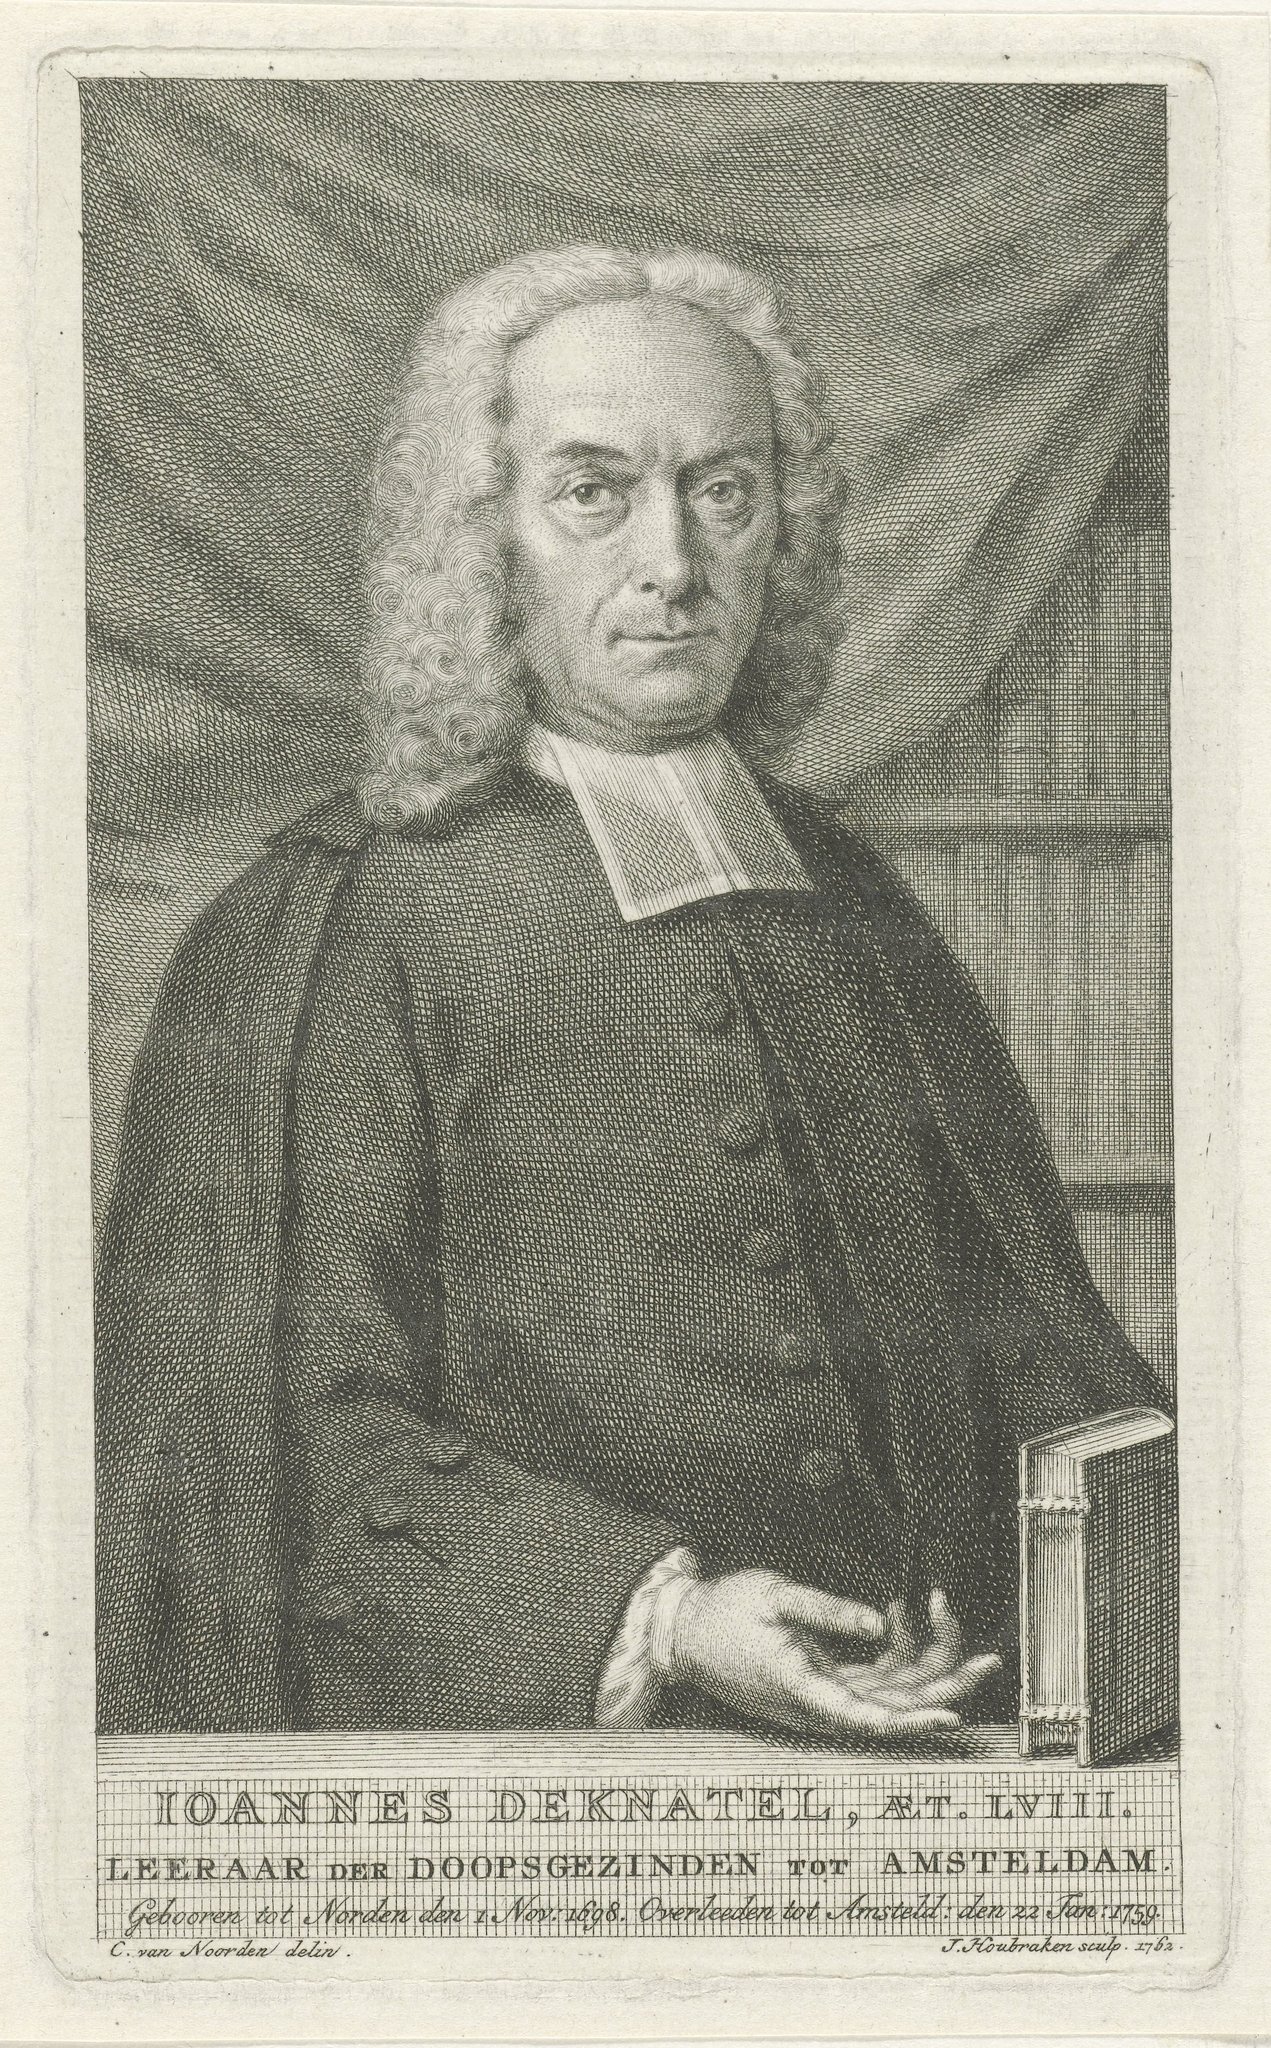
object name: print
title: Ioannes Deknatel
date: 1762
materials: paper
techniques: engraving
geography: amsterdam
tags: norden, joannes deknatel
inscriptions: collector's mark: Lugt 240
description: Portret ten halven lijve van Joannes Deknatel op 58-jarige leeftijd voor een gordijn en een boekenkast. Voor hem een plint waarop een bijbel en waarop zijn naam en gegevens in twee regels in het Nederlands.